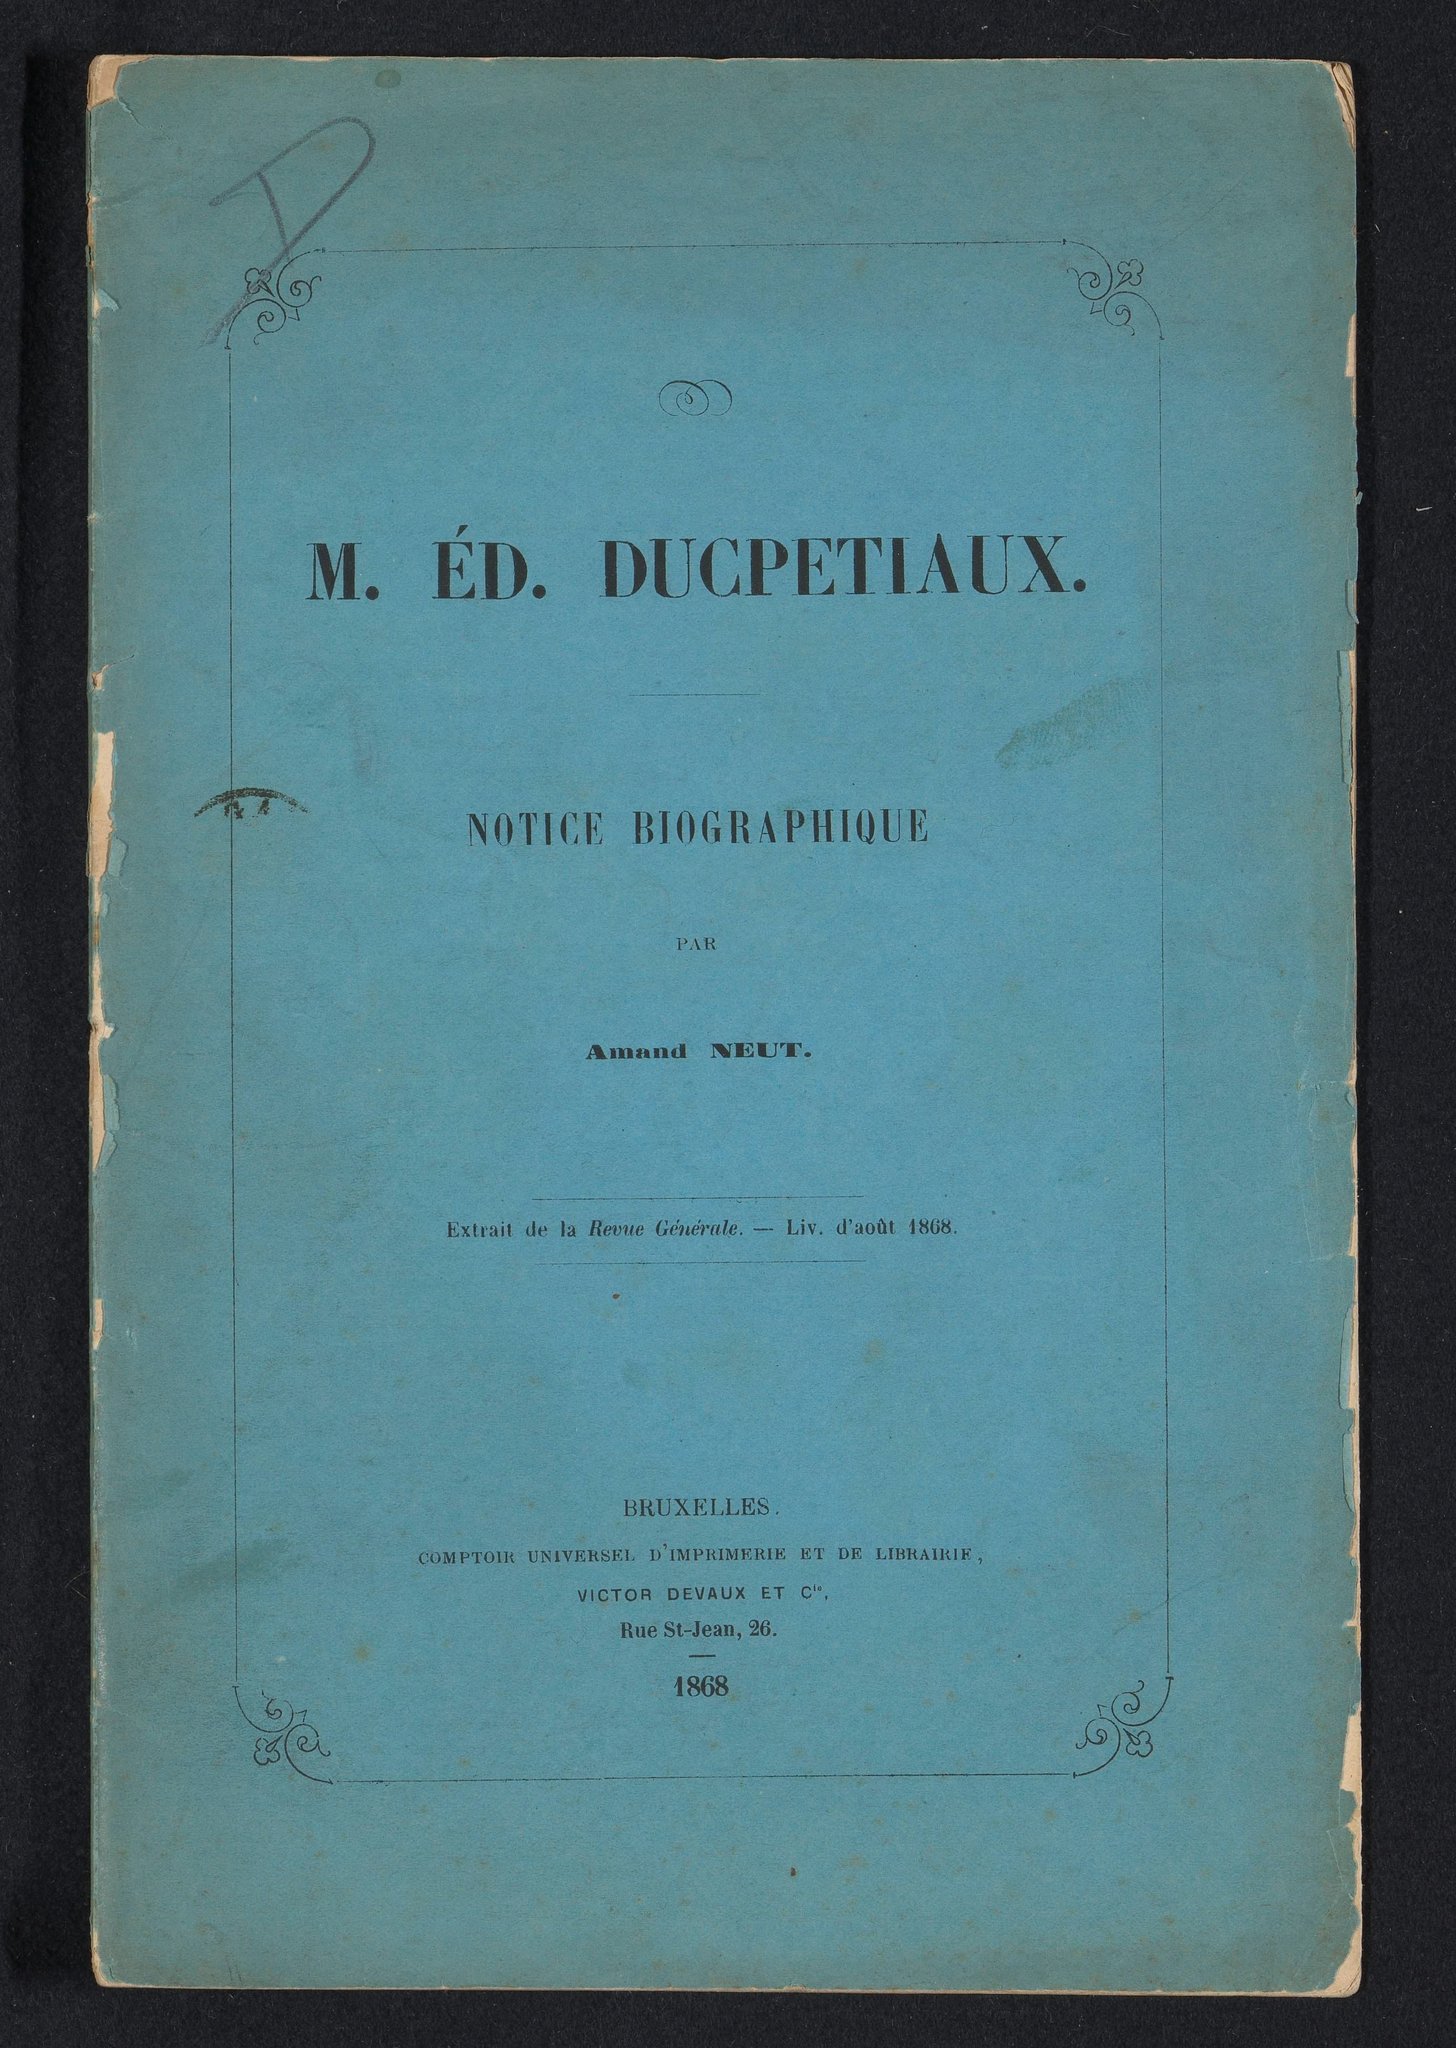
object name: book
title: M. Éd. Ducpétiaux notice biographique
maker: amand neut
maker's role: publicist, schrijver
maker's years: 1812-1884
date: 1868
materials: paper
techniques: printing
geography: brussels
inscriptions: name: ‘Hommage de l'Auteur A. Neut’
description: Zit samen met object RP-F-2001-7-149 in een insteekhoes.